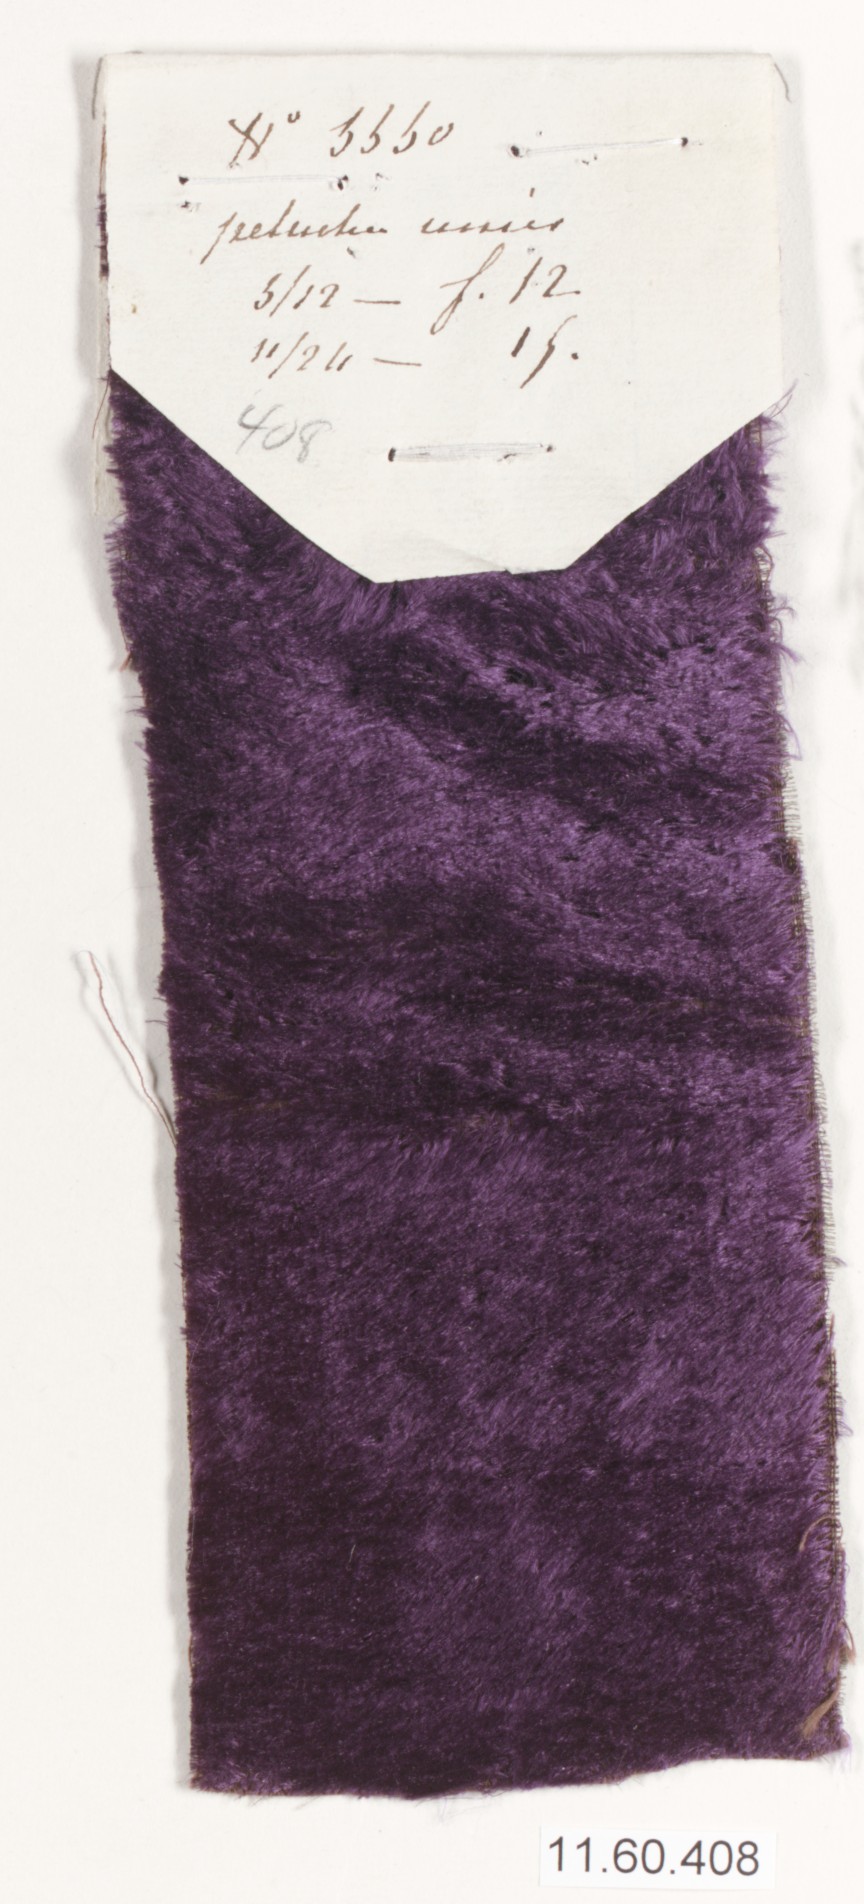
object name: fragment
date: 1801-1900